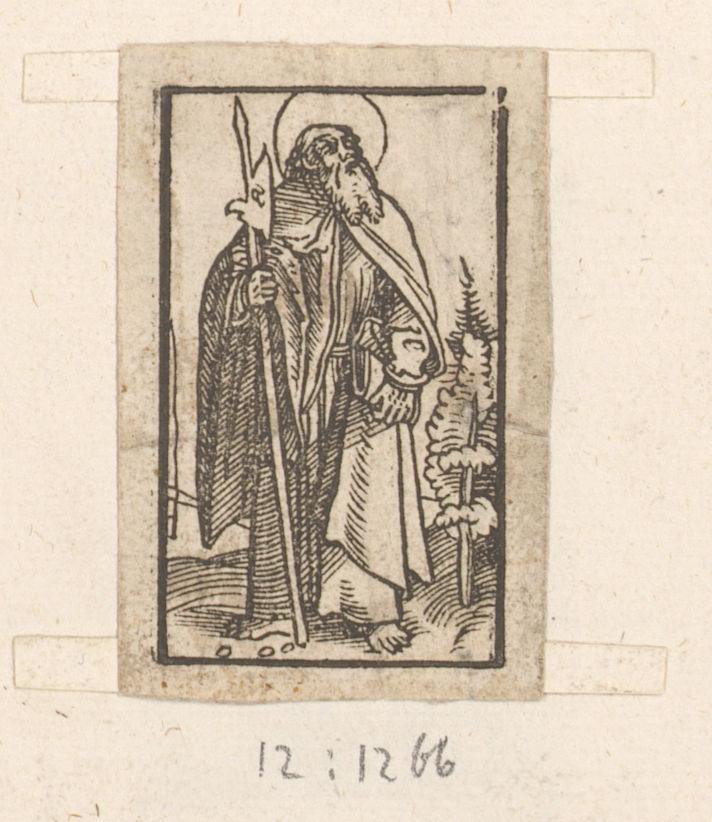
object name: print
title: Heiligen en de twaalf apostelen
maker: Anonymous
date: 1500-1550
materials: paper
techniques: woodcut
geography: germany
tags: the apostle and evangelist matthew (mattheus); possible attributes: angel, axe, book, halberd, pen and inkhorn, purse, scroll, square, sword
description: De apostel Matteüs met hellebaard in de hand. Prent maakt deel uit van een album.